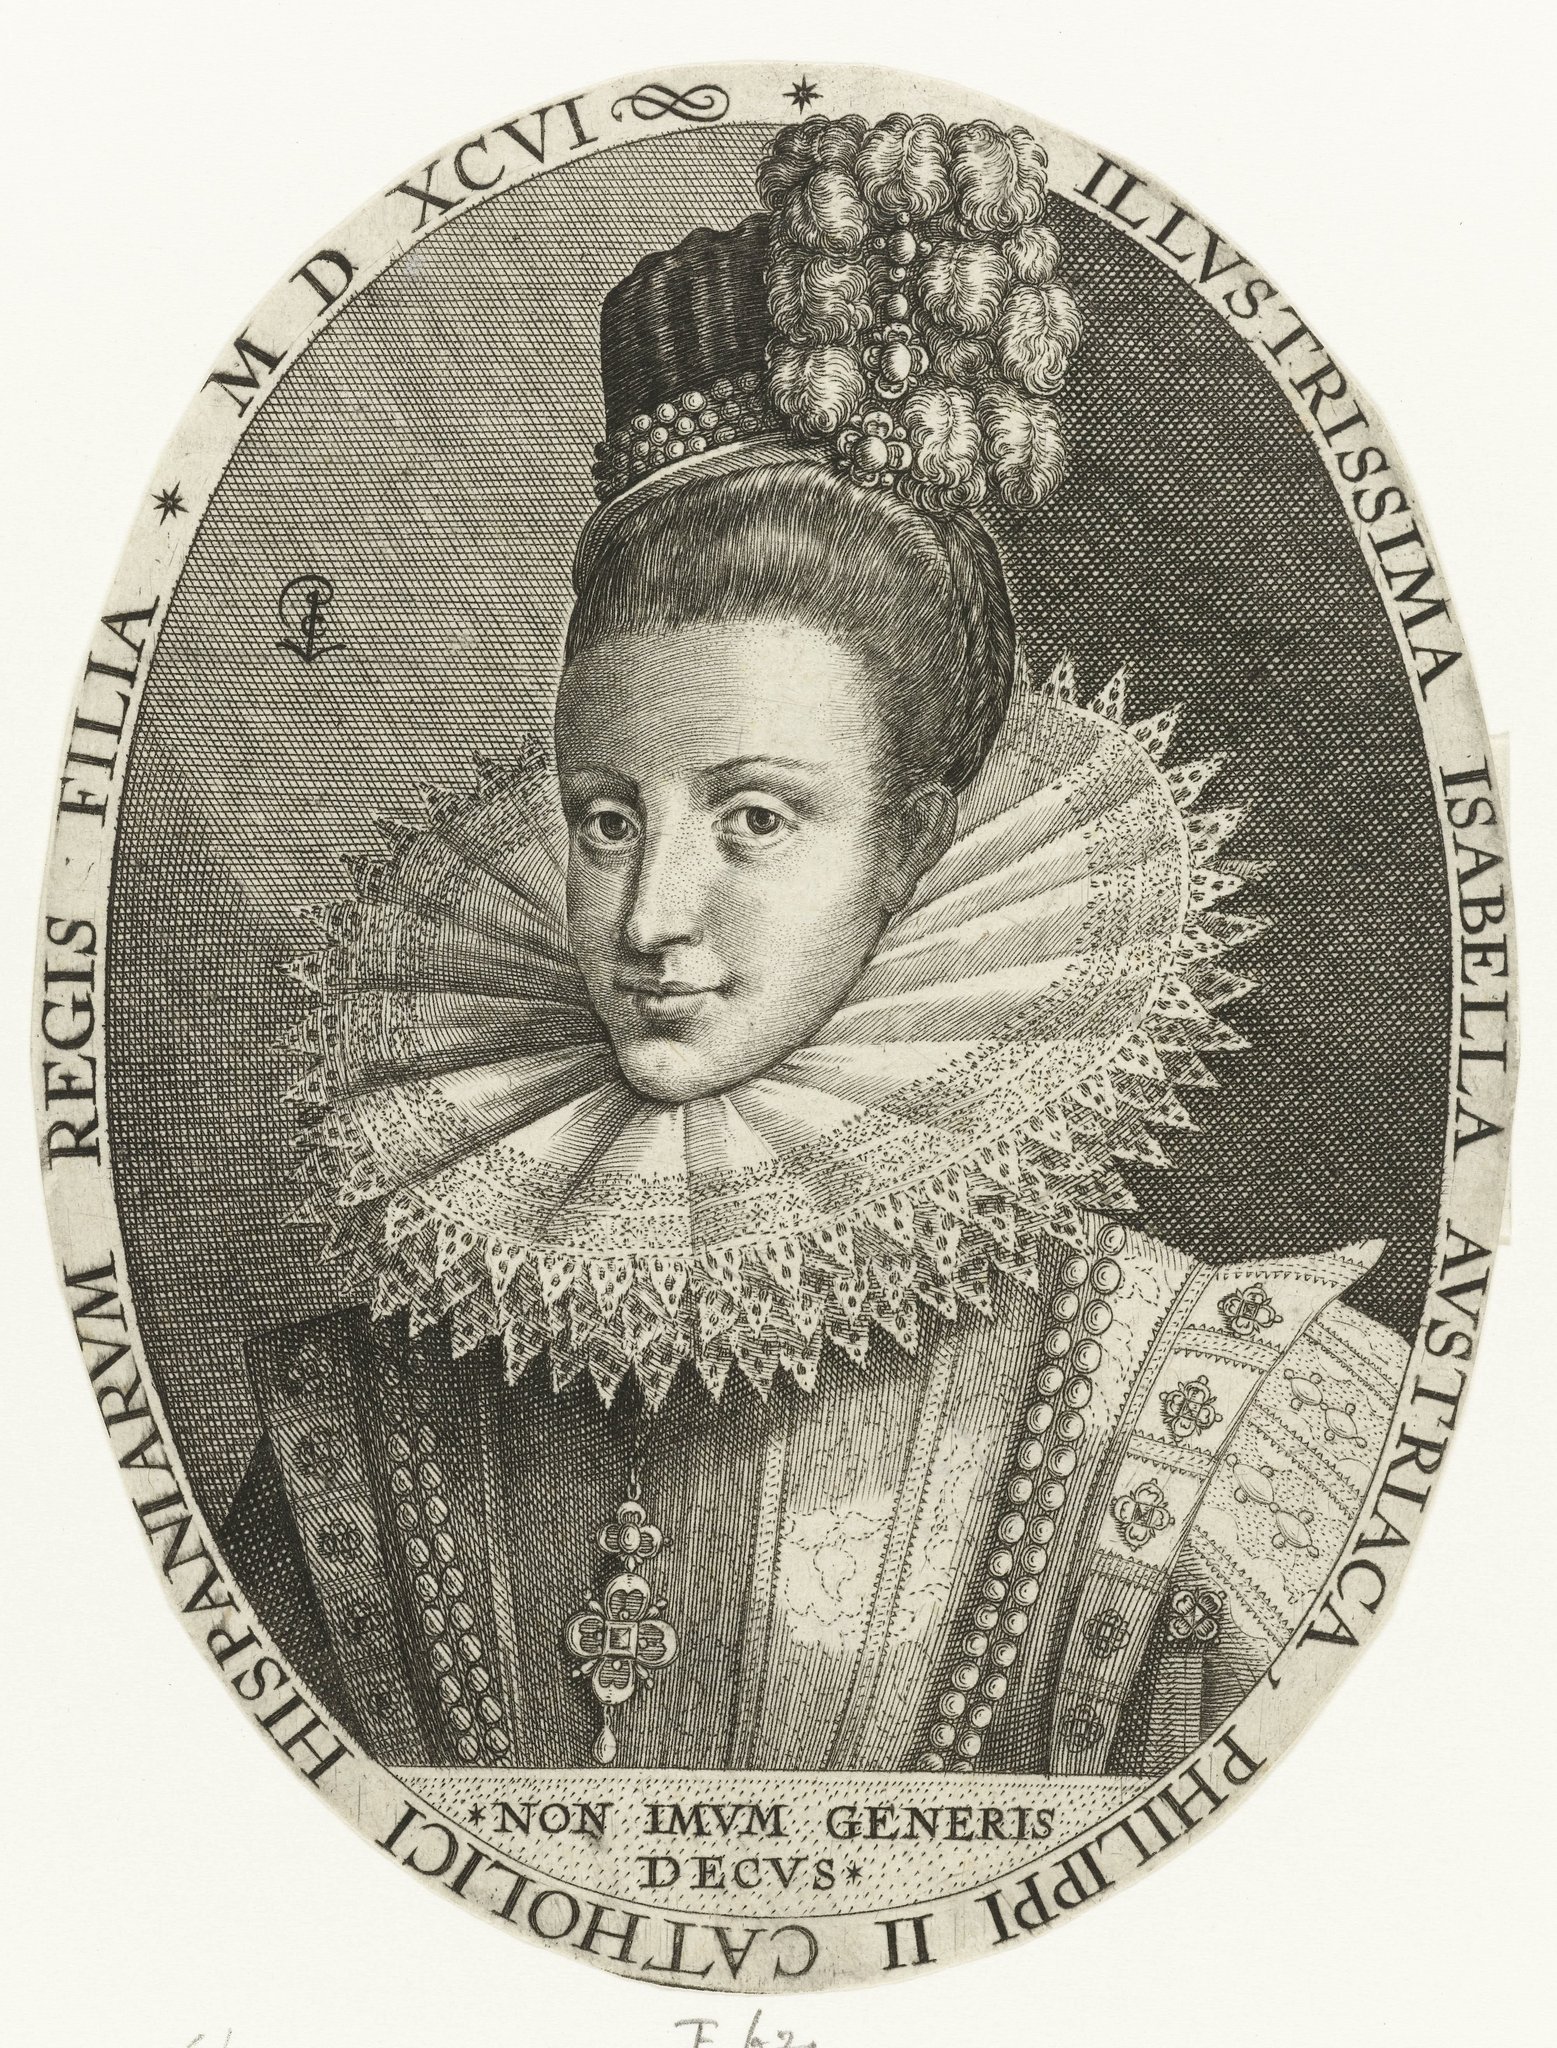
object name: print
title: Busteportret van Isabella Clara Eugenia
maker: crispijn van de passe (i)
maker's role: draughtsman, print maker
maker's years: 1564-1637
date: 1596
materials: paper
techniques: engraving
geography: cologne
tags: infante van spanje isabella clara eugenia, pendant, trinket, 'breloque' (+ women's clothes), head-gear: toque (+ women's clothes), historical persons - bb - woman, neck-gear ~ clothing (ruff) (+ lace used for clothes), neck-gear ~ clothing (with name) (+ women's clothes), sleeves (+ women's clothes), necklace (+ women's clothes), pearl; pearl necklace (+ women's clothes)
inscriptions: date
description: Kleding: driedubbele ingerimpelde kraag met brede rand van kant. Platte schouderkleppen. Toque, gegarneerd met edelstenen en veren. Om de hals een ketting met hanger.